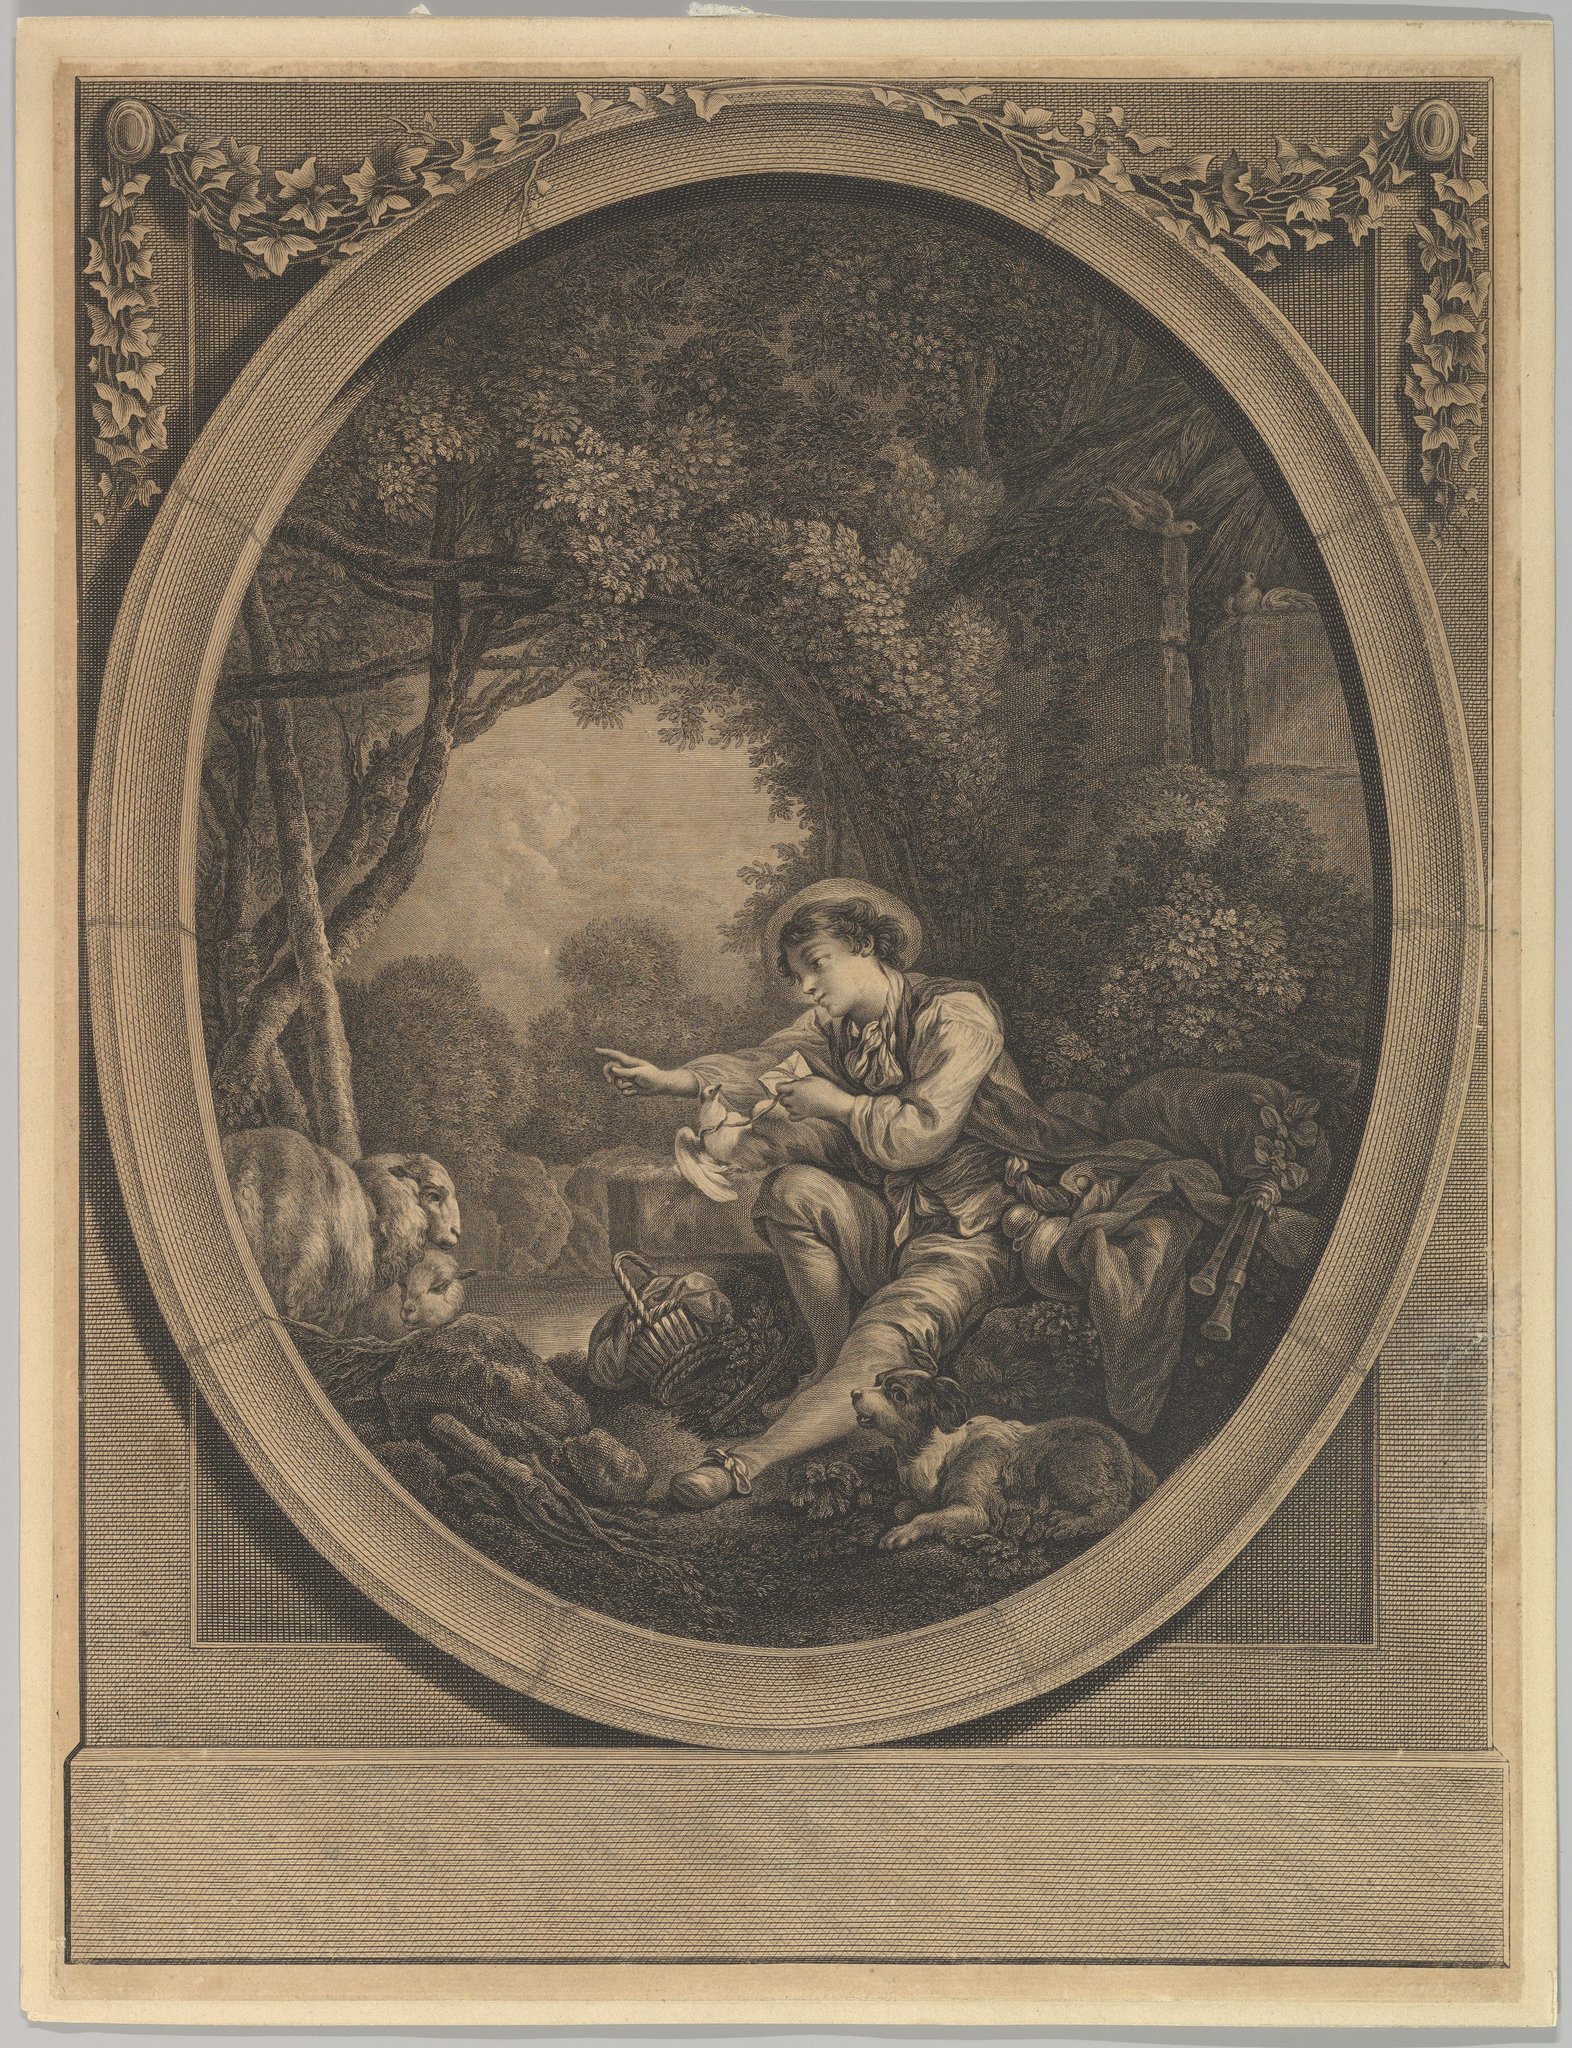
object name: print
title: L'Départ du Courier (The Departure of the Messenger)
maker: jacques firmin beauvarlet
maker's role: artist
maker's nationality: french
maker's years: 1731-1797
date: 1701-1800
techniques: engraving, etching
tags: boys,dogs,sheep